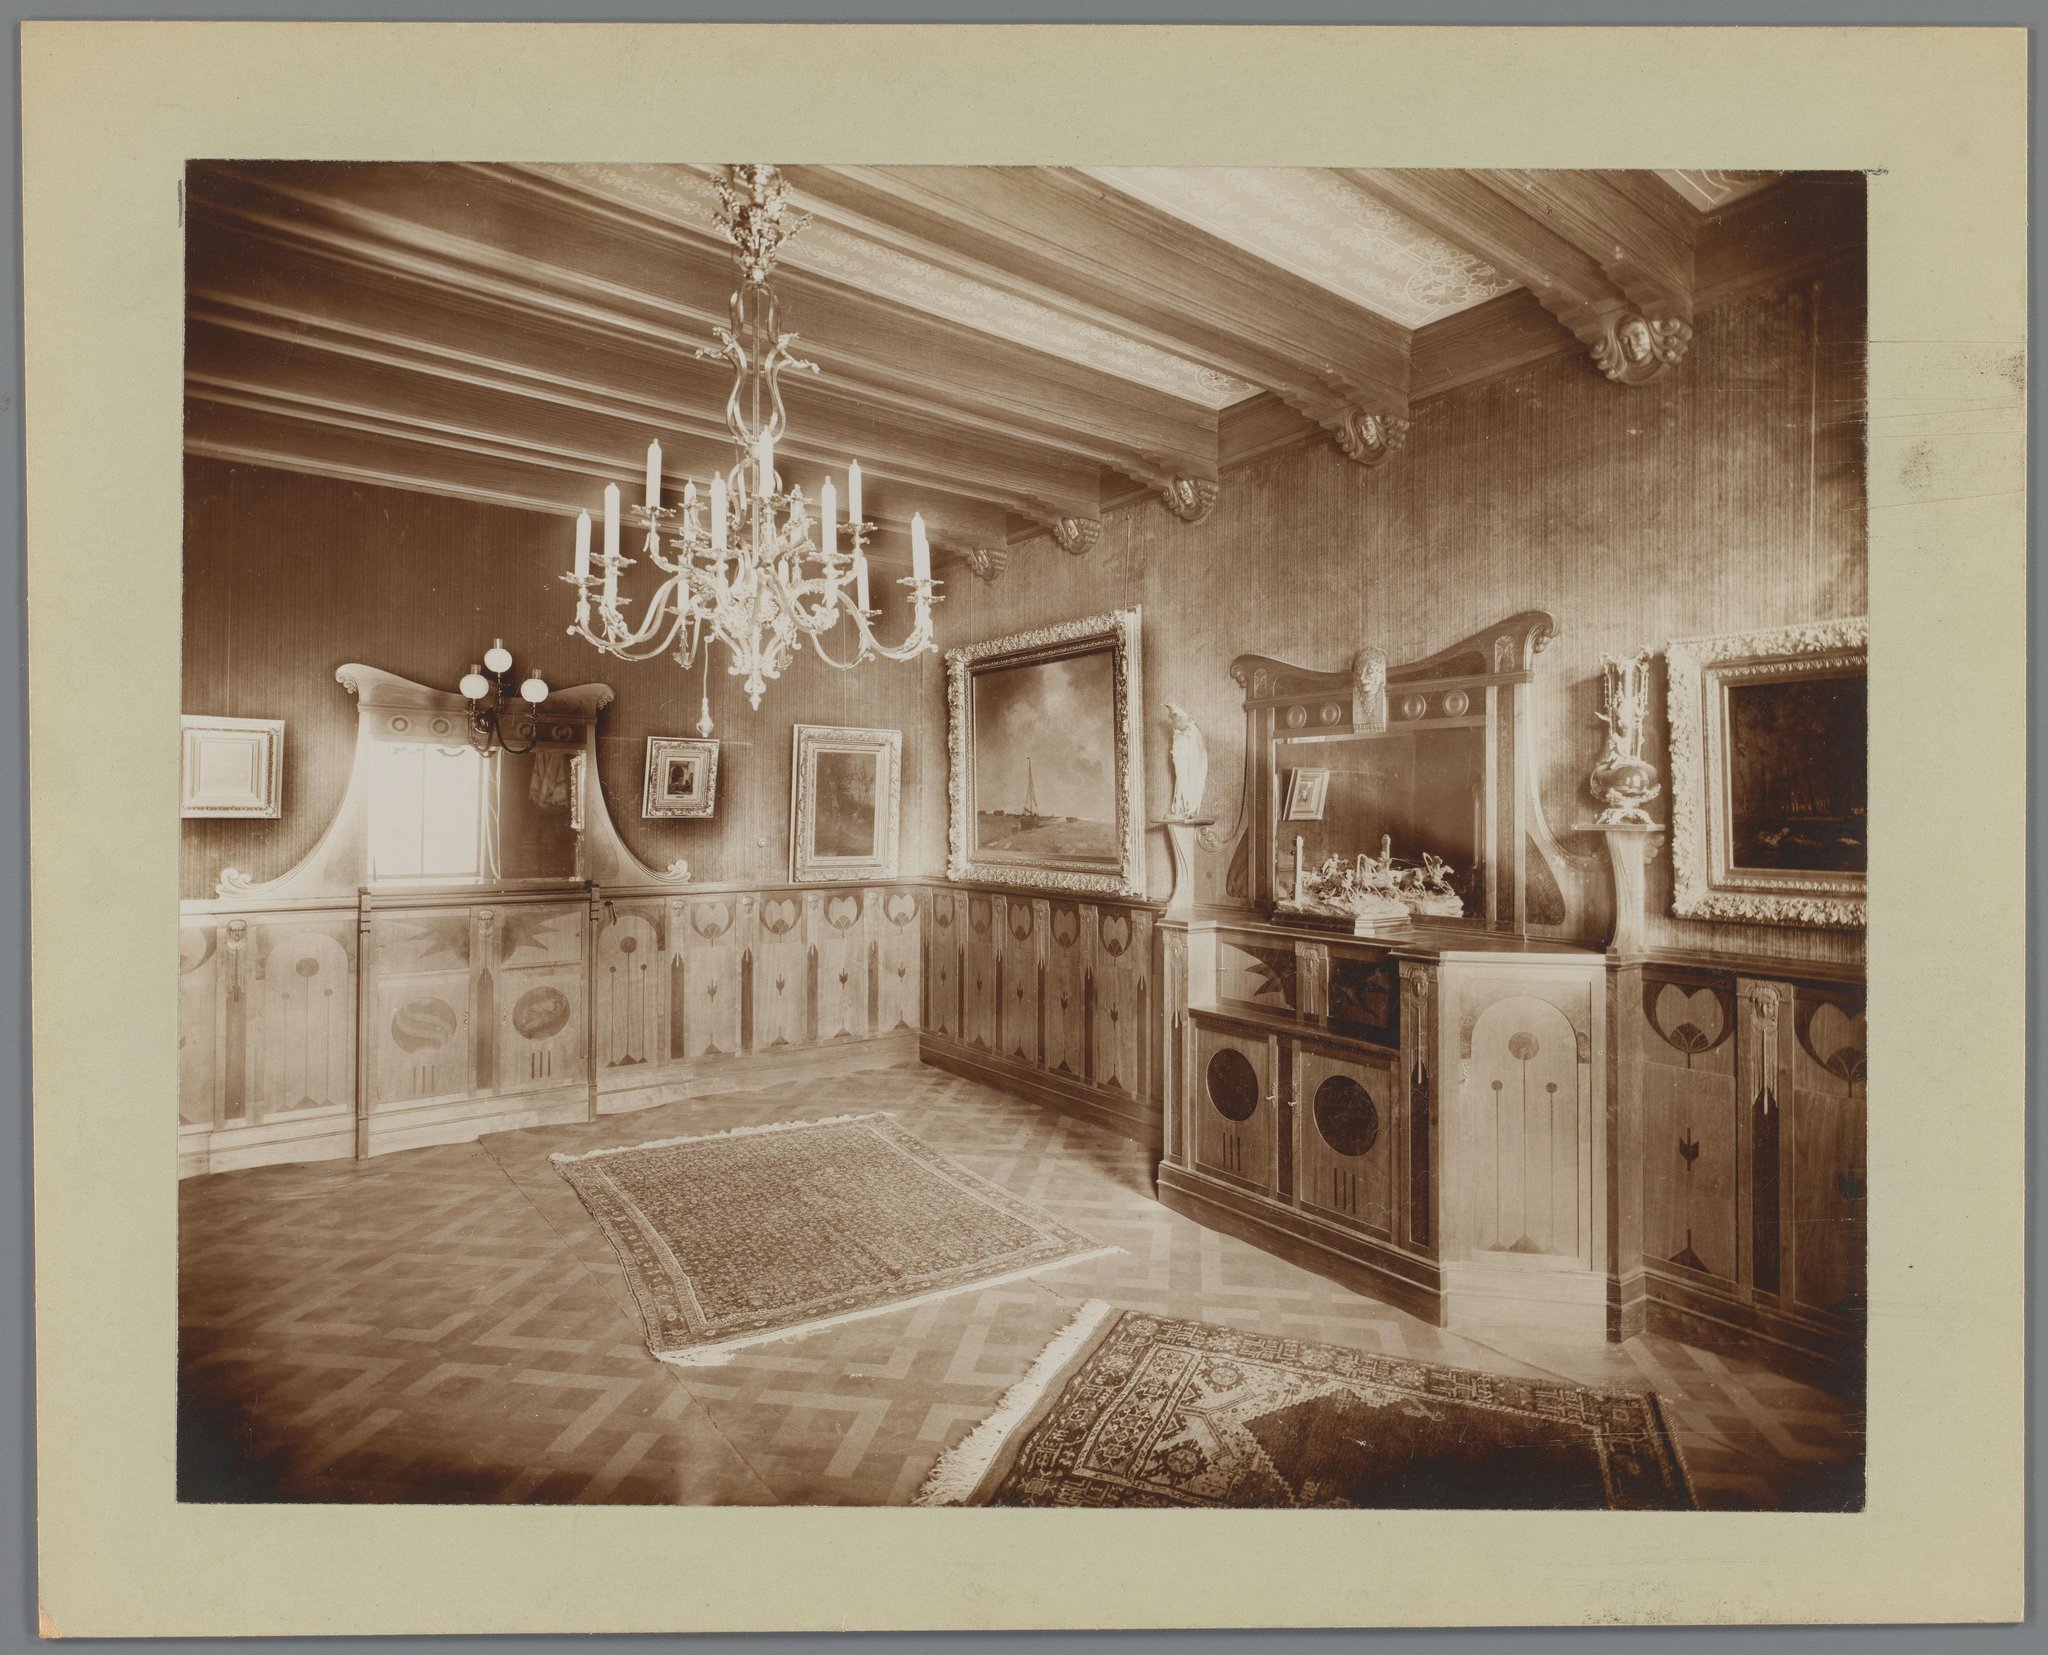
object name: photograph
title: Interieur van Keizersgracht 58, Amsterdam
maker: Anonymous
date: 1901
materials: paper, cardboard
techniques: collodion silver print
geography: amsterdam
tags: living-room, parlour, sitting-room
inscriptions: inscription: ‘Zaal, Keizersgracht, 58./ November, 1901.’